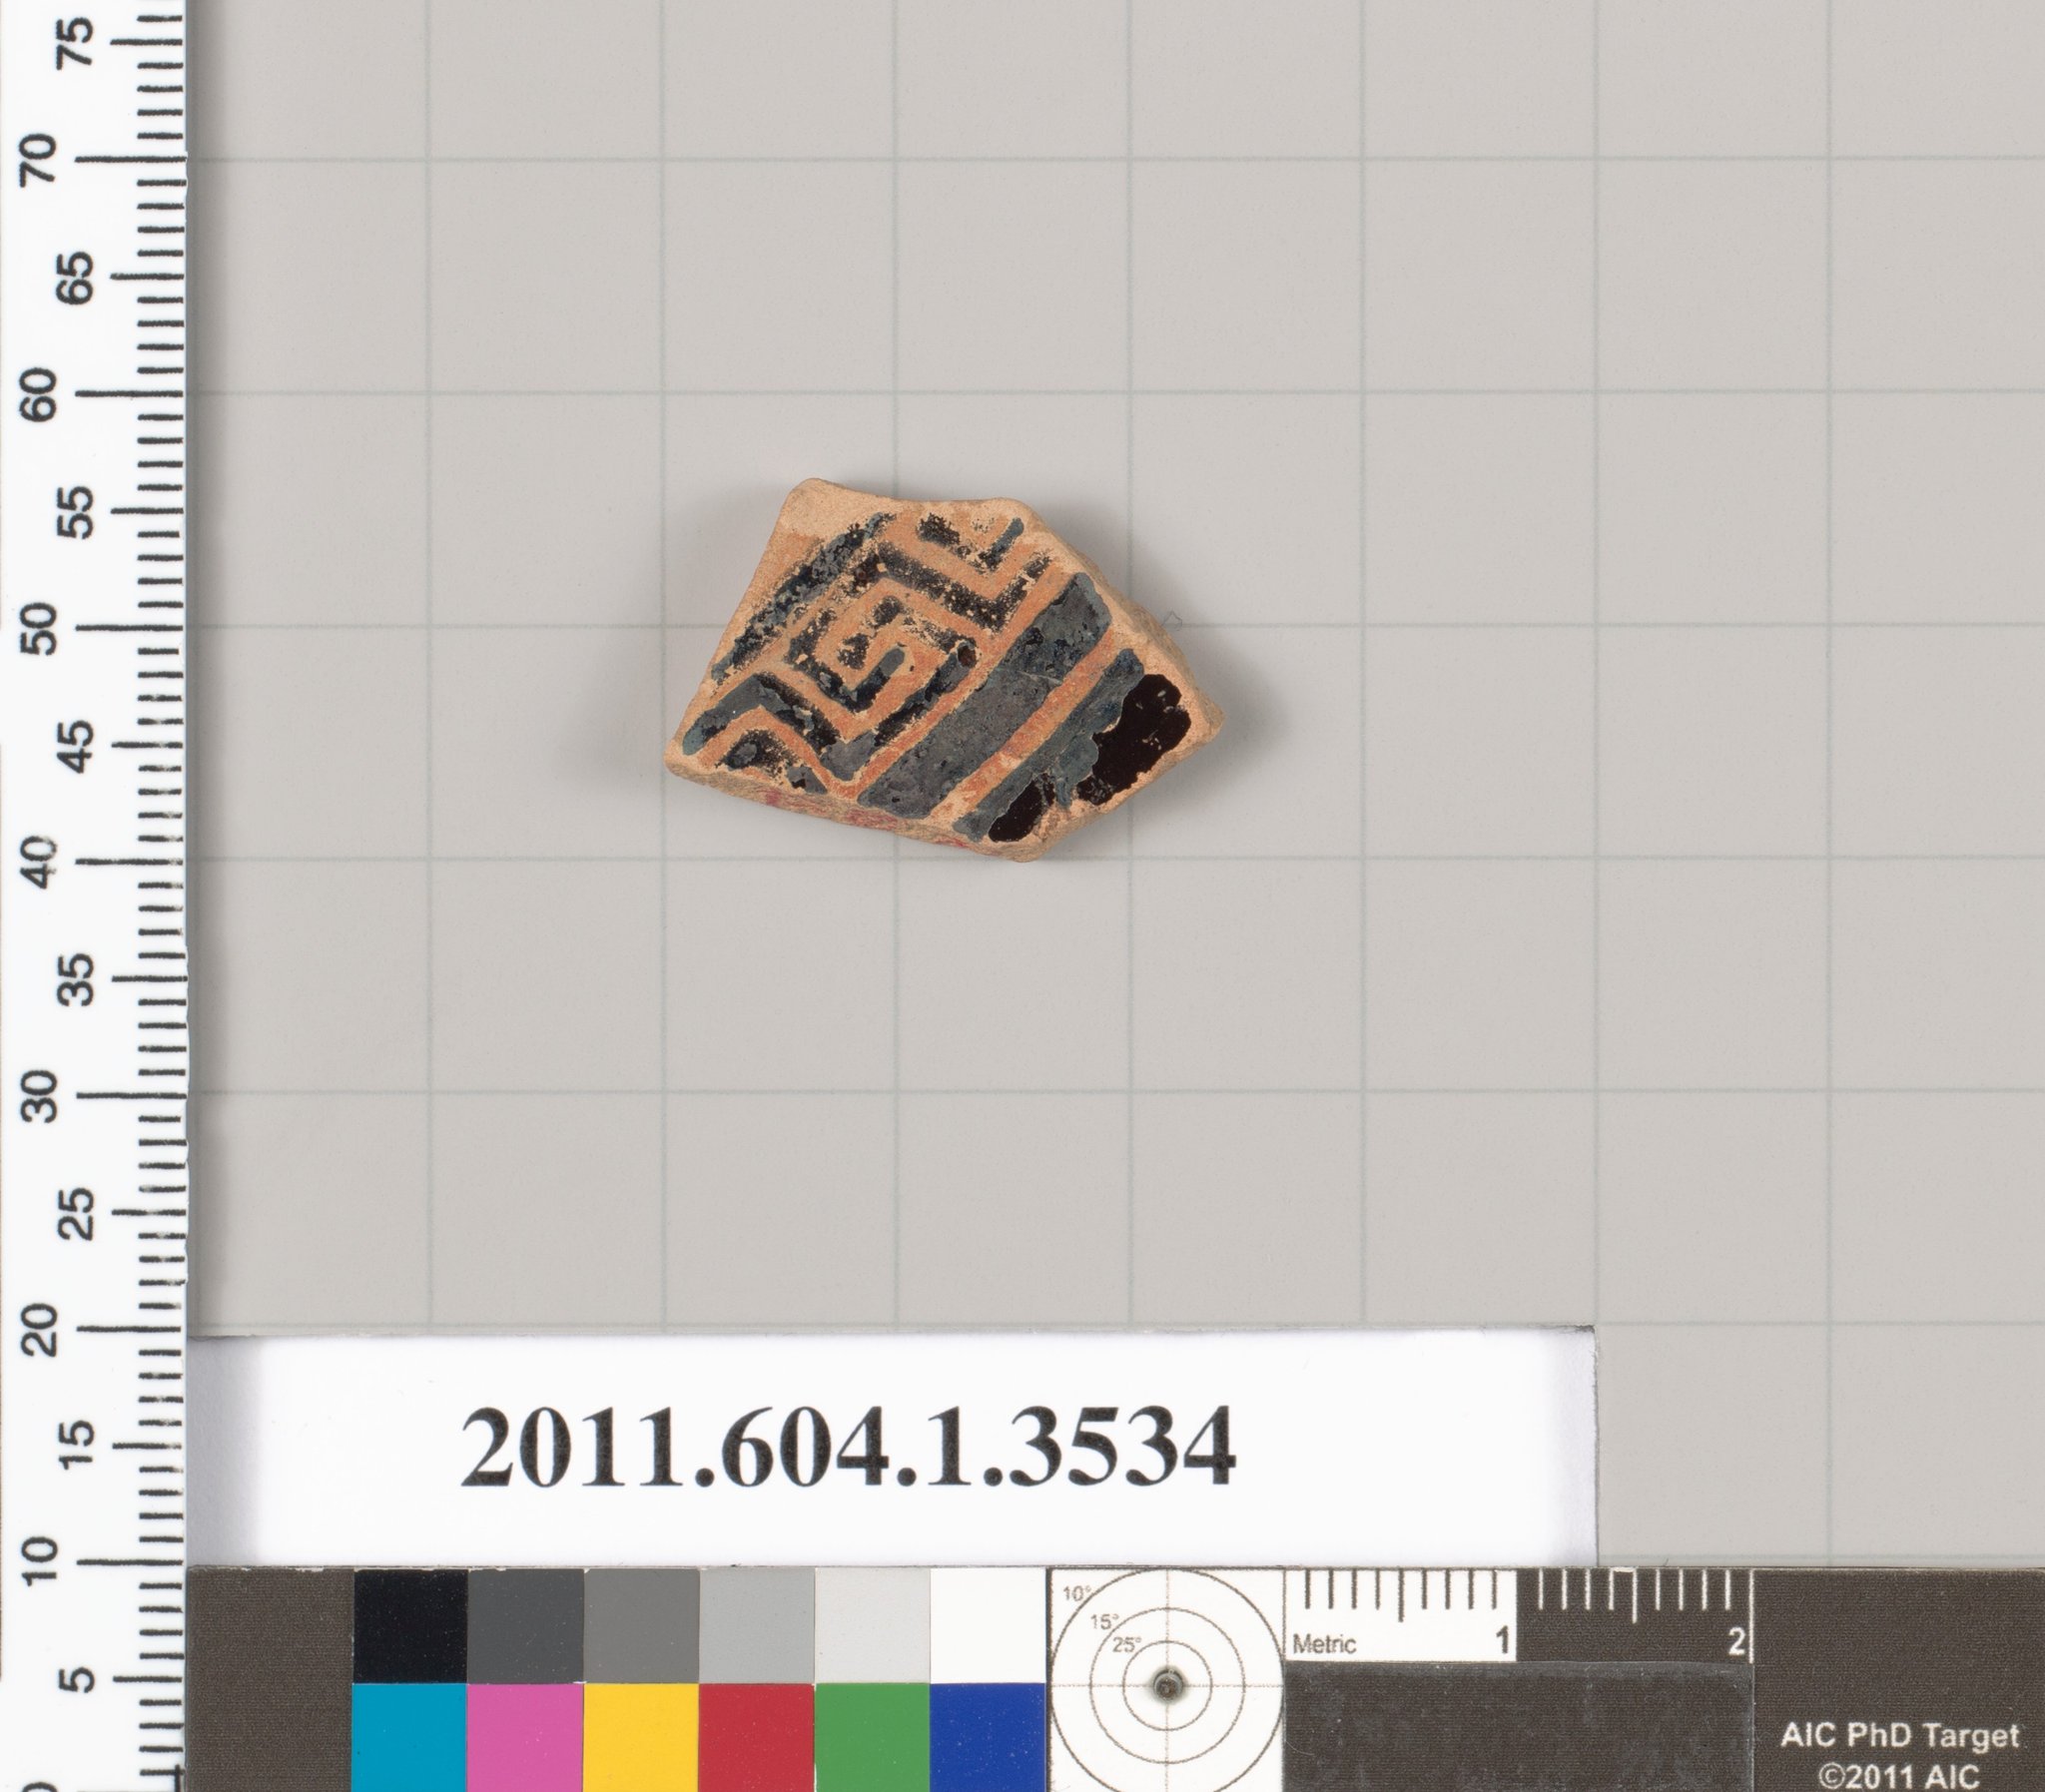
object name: kylix fragment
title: Terracotta fragment of a kylix (drinking cup)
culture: greek, attic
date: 475-451 BCE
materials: terracotta